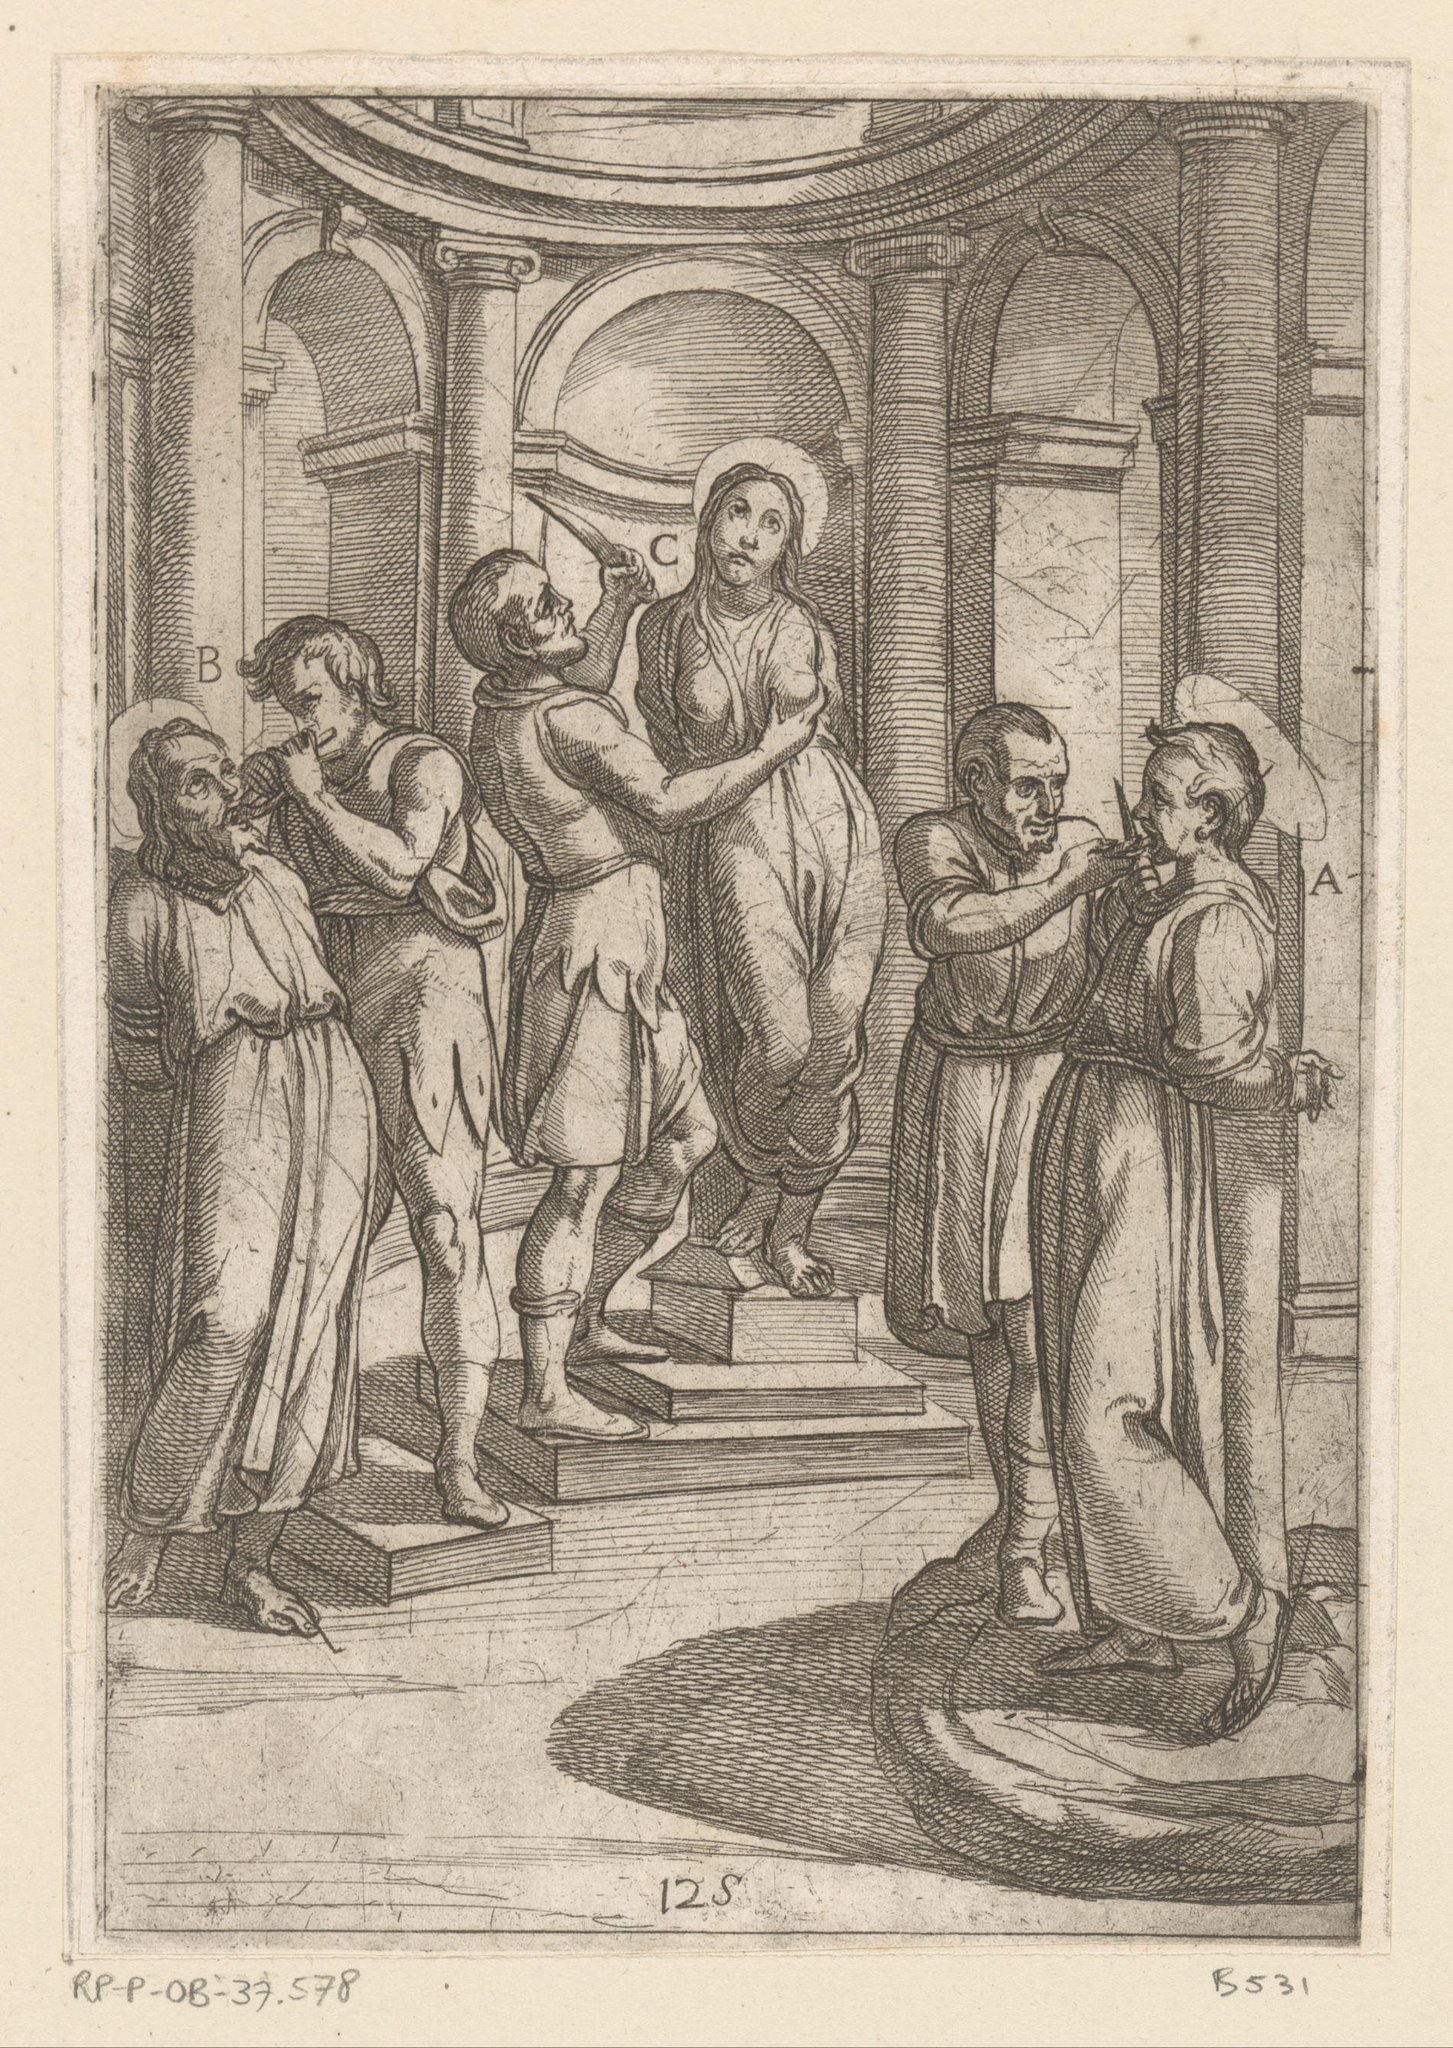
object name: print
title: Foltering: verminking van het gezicht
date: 1565-1630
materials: paper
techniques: etching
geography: vatican city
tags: violent death ~ maltreatment, torture, torture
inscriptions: collector's mark: Lugt 240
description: Deze prent maakt deel uit van een reeks van 47 prenten (+ titelprent) met voorstellingen van martelmethoden. Deze prenten zijn in een andere editie gebruikt als illustraties voor Antonio Gallonio's 'Trattato degli Instrumenti di Martirio e delle Varie Maniere di Martoriare Usate dai Gentili contro Christiani' (Rome, Ascanio en Girolamo Dongangeli, 1591).